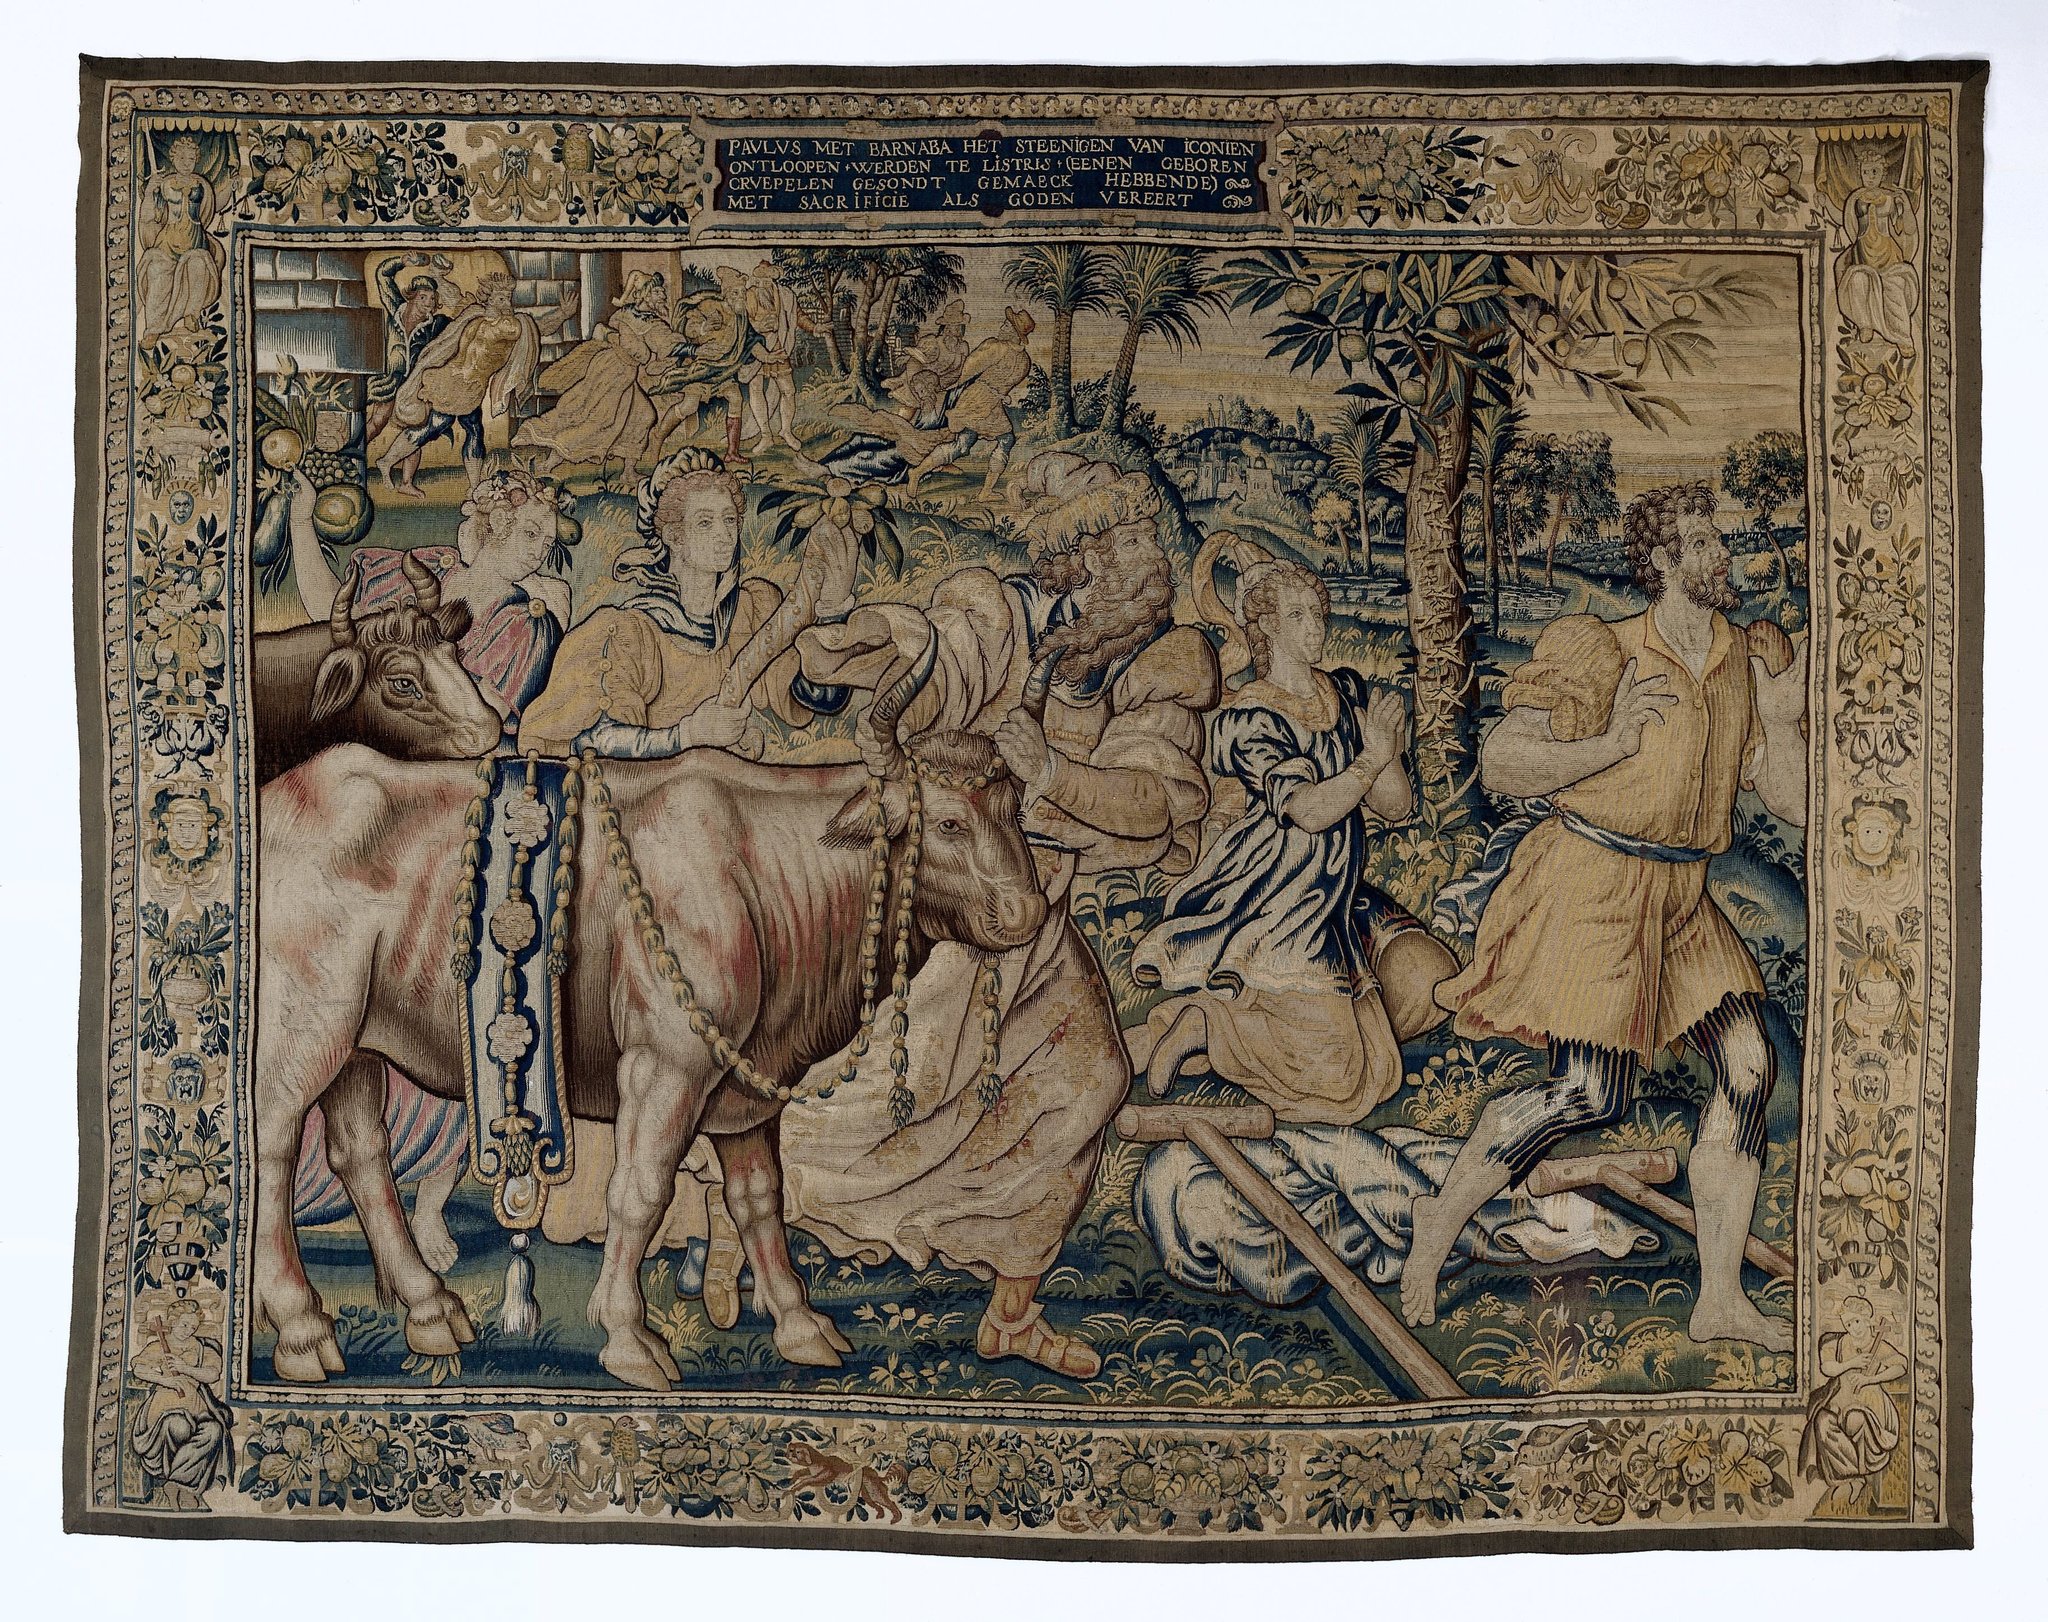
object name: tapestry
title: Het offer te Lystra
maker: Anonymous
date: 1550-1600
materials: silk, wool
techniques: tapestry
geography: southern netherlands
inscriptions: mark: ‘onbekend merk’, : ‘PAVLVS MET BARNABA HET STEENIGEN VAN ICONIEN // ONTLOOPEN. WERDEN TE LISTRIS (EENEN GEBOREN // CRVEPELEN GESONDT GEMAECK HEBBENDE) // MET SACREFICIE ALS GODEN VEREERT’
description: Wandtapijt met Paulus en Barnabas te Lystra. Onbekend weversmerk.